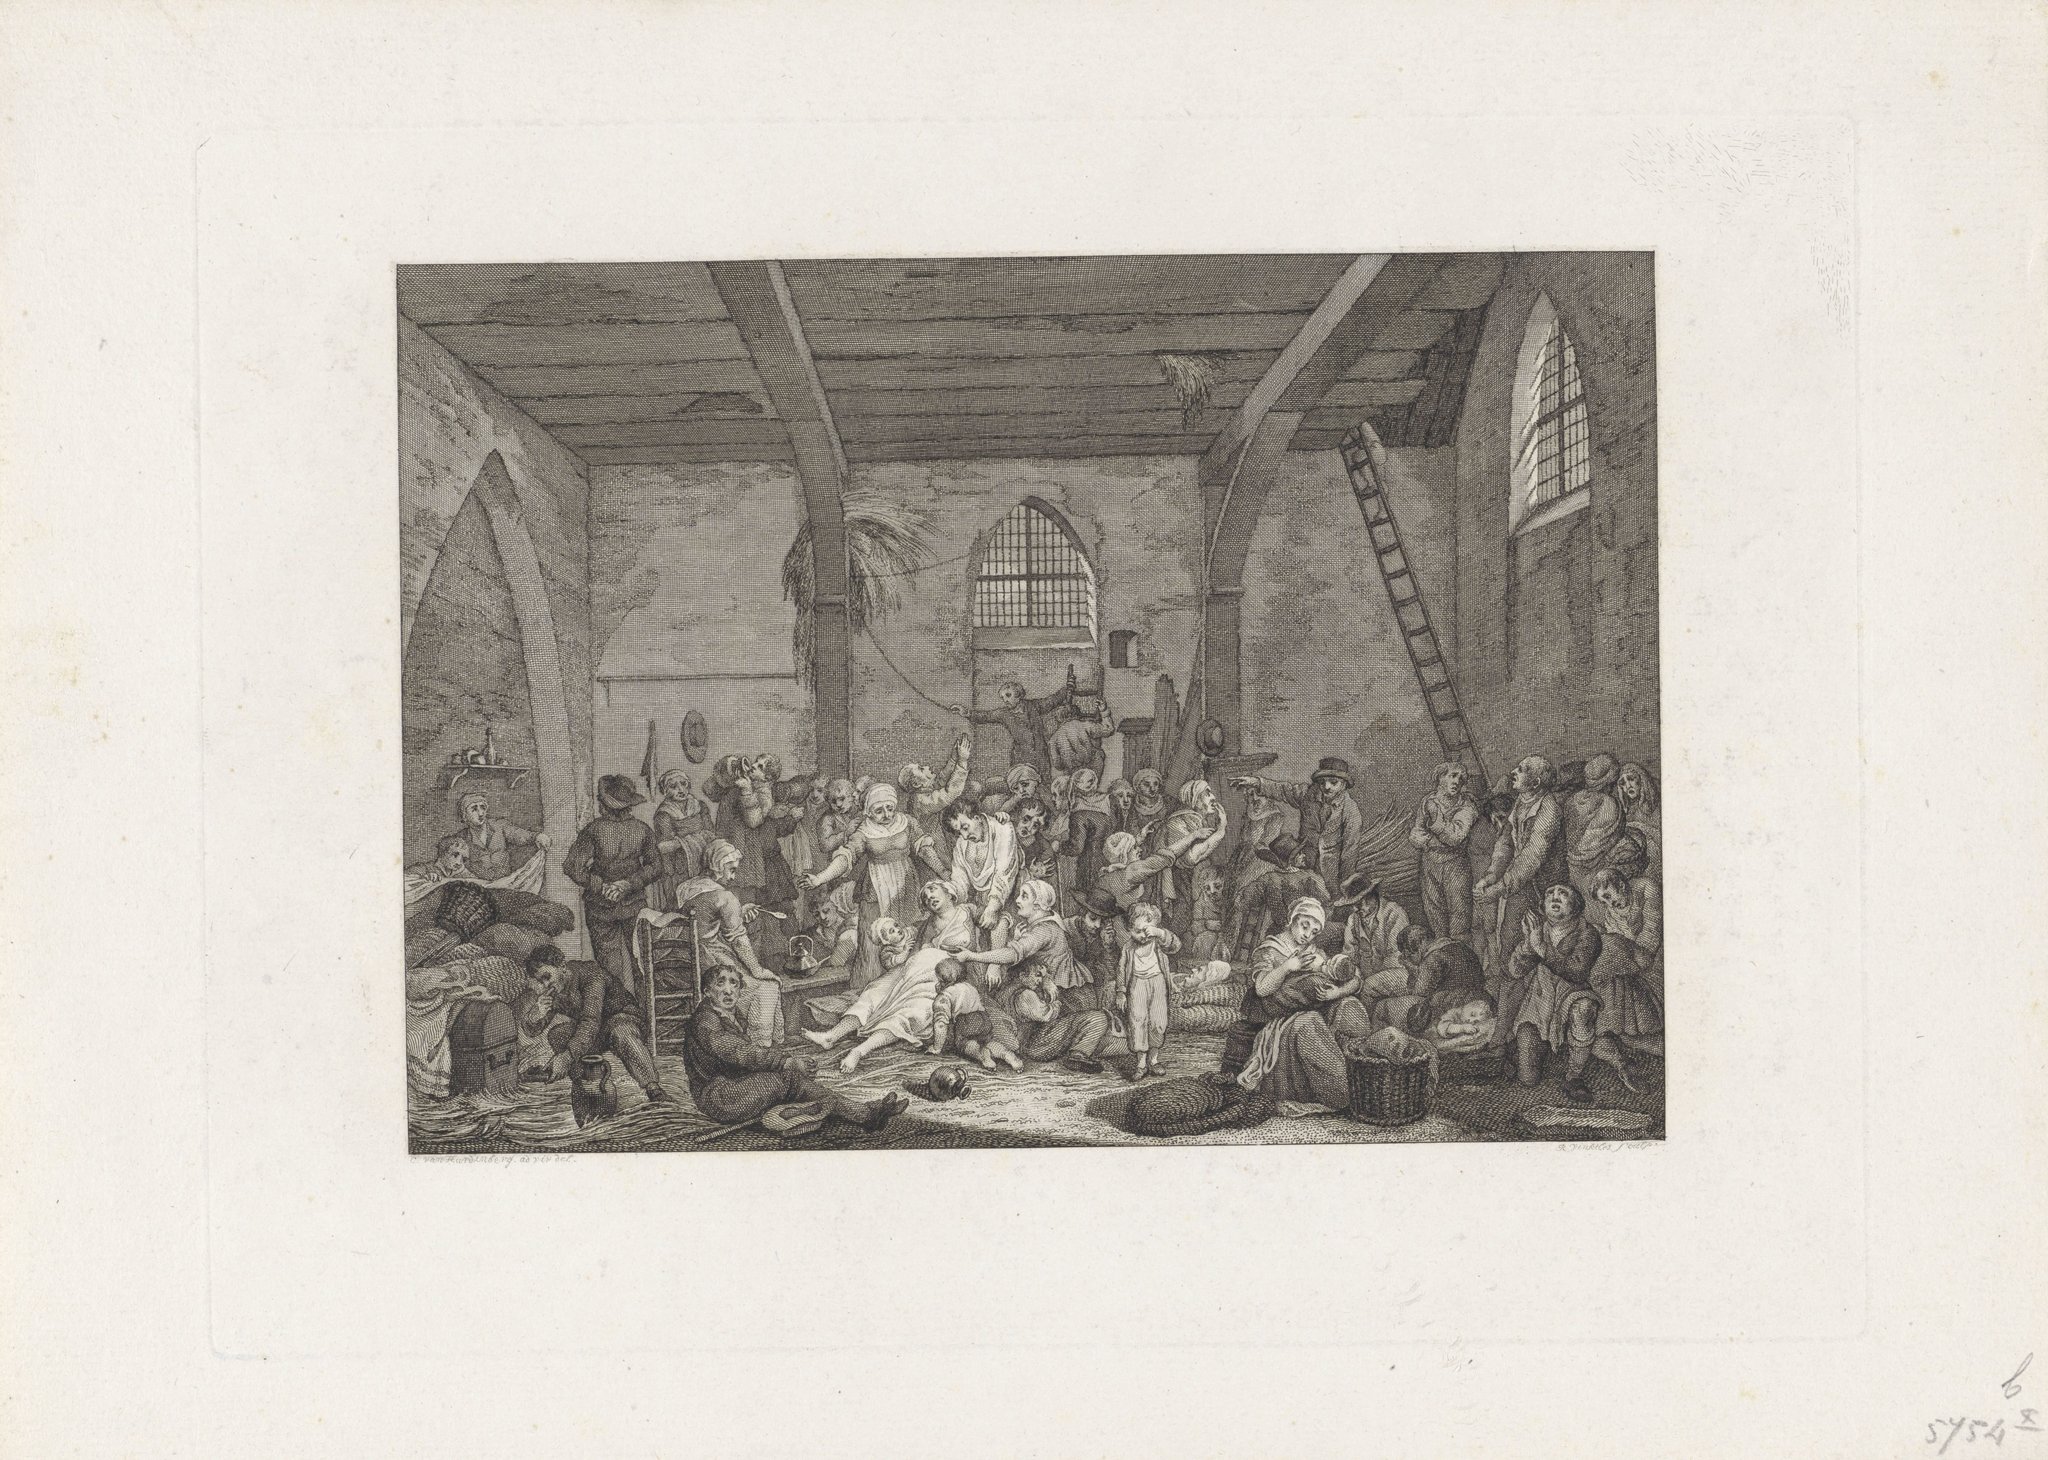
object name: print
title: Getroffenen van de overstroming in een kapel te Babyloniënbroek, 1809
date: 1809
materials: paper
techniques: engraving, etching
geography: amsterdam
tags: ruin of church, monastery, etc. - qq - small church, chapel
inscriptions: collector's mark: Lugt 2228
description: Illustratie voor: Ewijk, Hendrik. Geschiedkundig verslag der dijkbreuken en overstroomingen in Holland, in 1809. Amsterdam: J. Allart en J. Ruys, 1809.